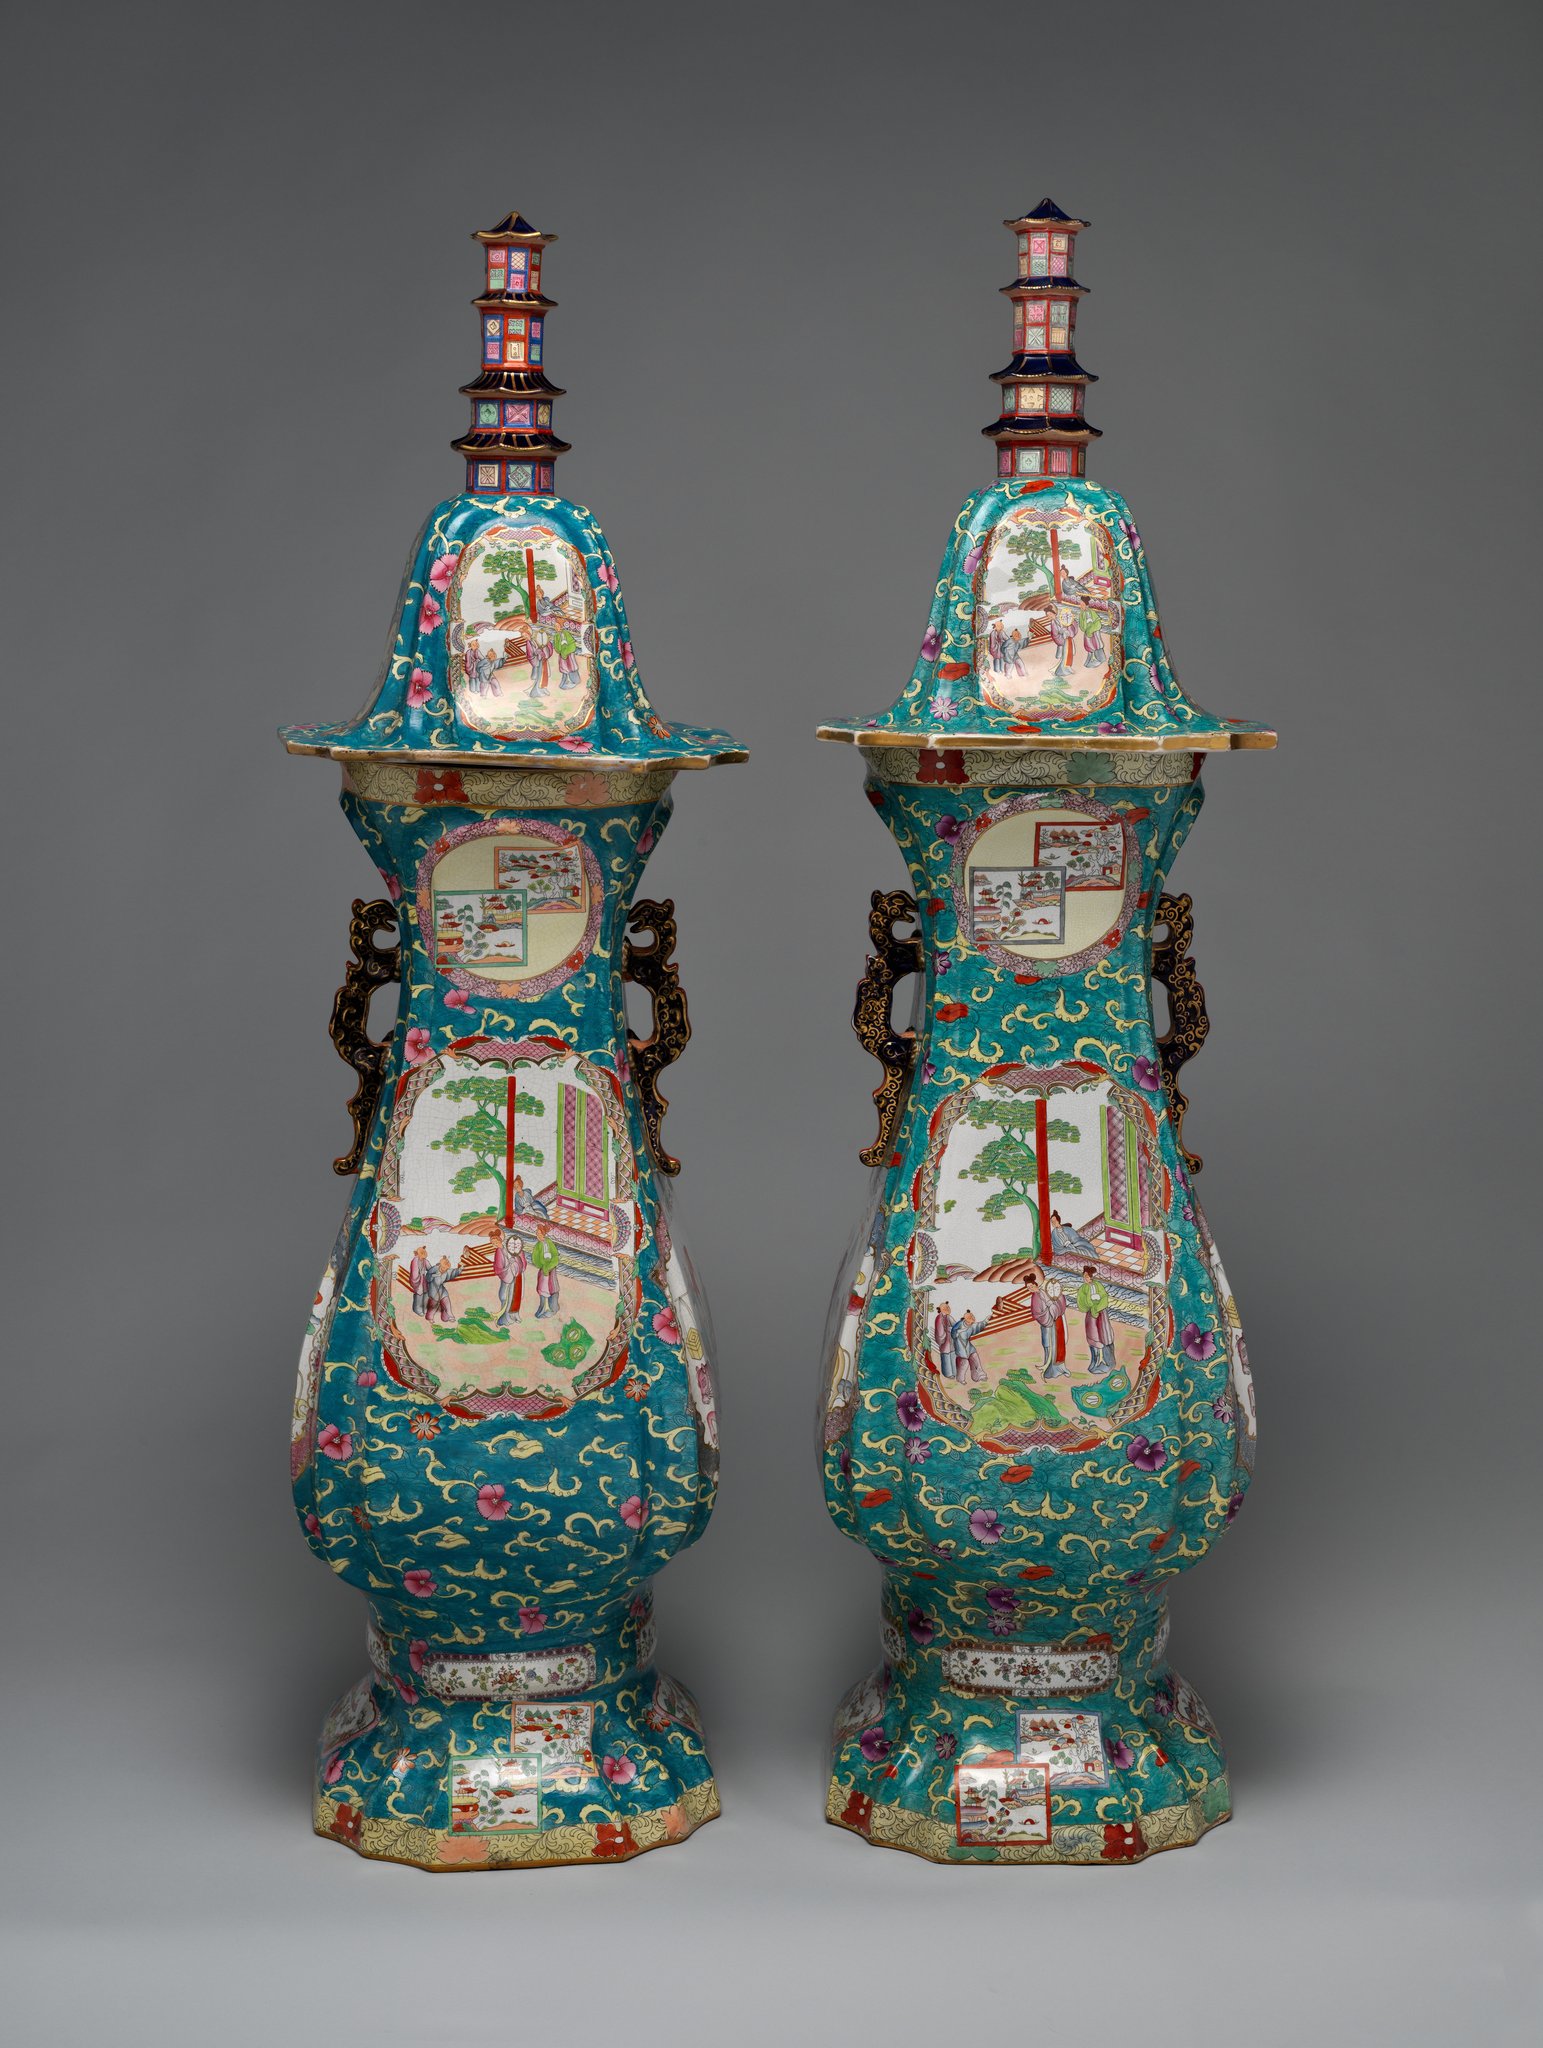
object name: vase with cover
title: Vase with lid (one of a pair)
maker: c. j. mason and co.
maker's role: manufactory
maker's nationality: british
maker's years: 1826-1848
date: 1826-1845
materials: earthenware, enamel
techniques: transfer